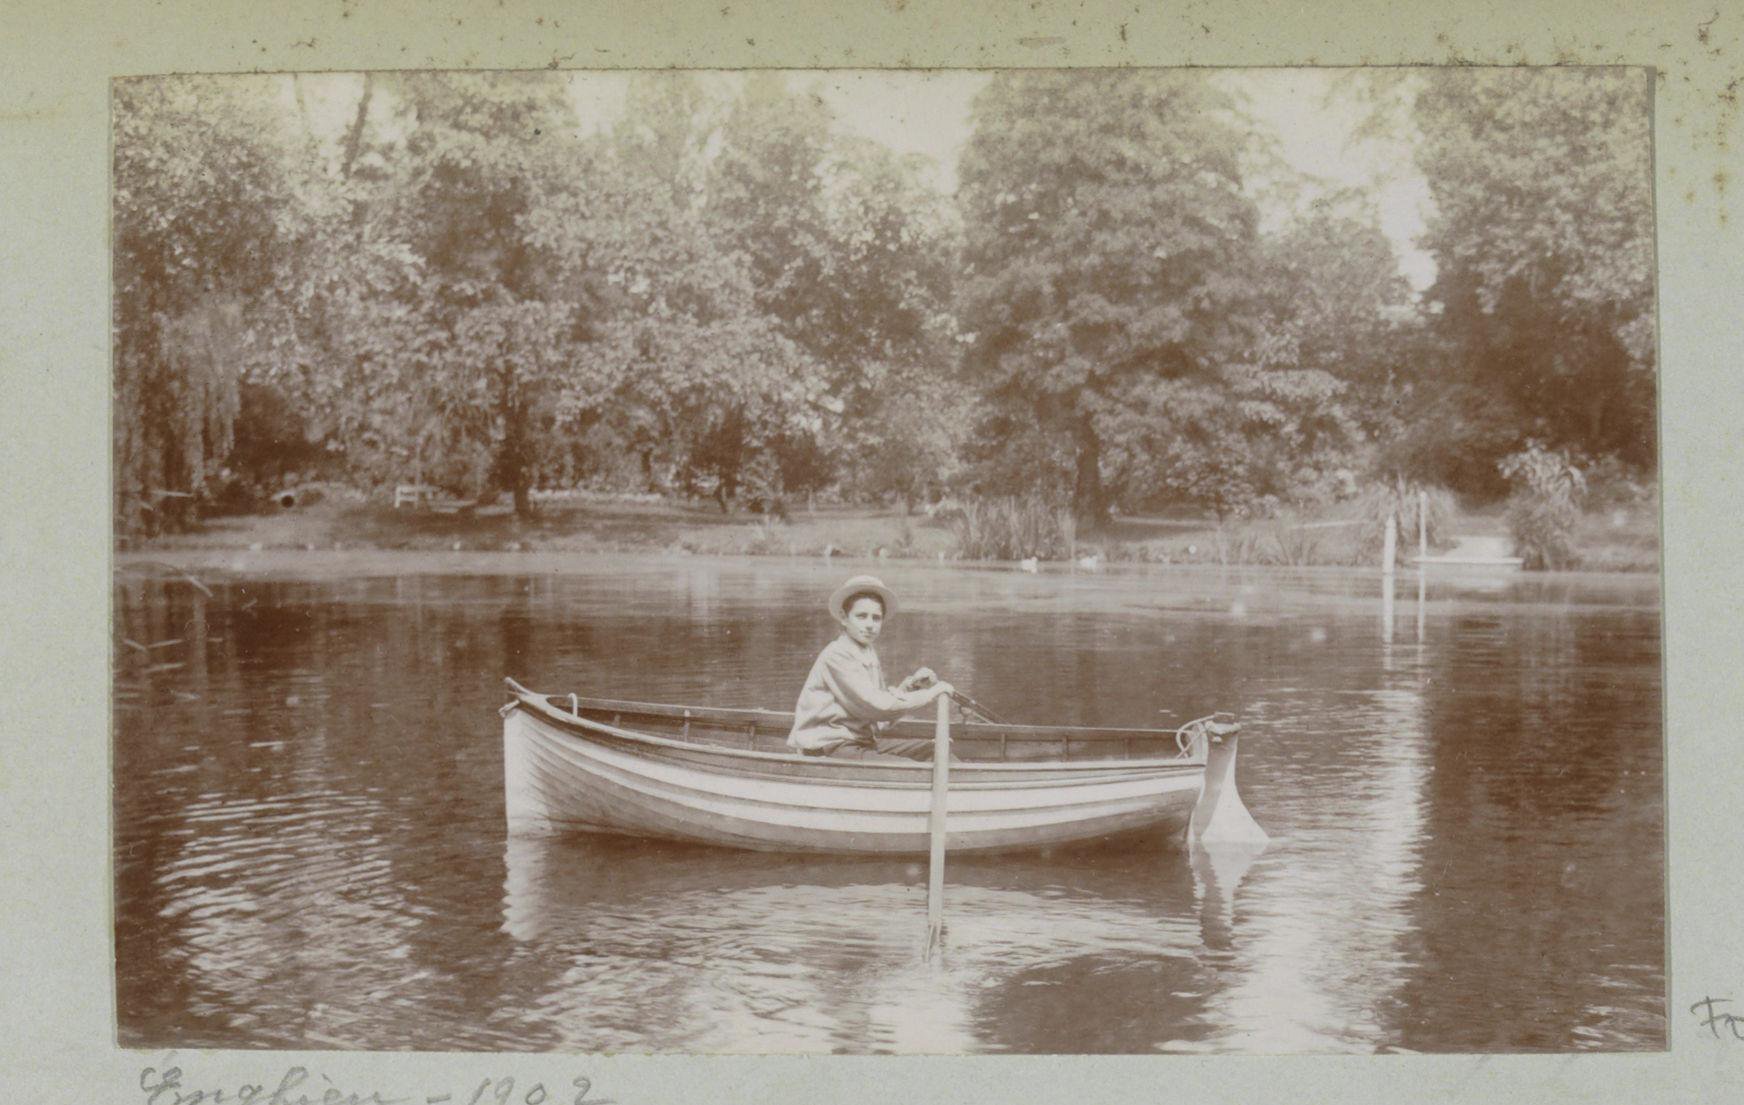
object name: photograph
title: Jongen in een roeiboot op een water in Enghien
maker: delizy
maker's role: manufacturer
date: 1902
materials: paper, photographic support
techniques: gelatin silver print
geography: edingen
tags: youth, adolescent, rowing-boat, canoe, etc.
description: Onderdeel van Fotoalbum van een Franse amateurfotograaf met opnames van uitstapjes in Frankrijk, Spanje, België, Luxemburg en Nederland, de eerste automobielen en autoraces.